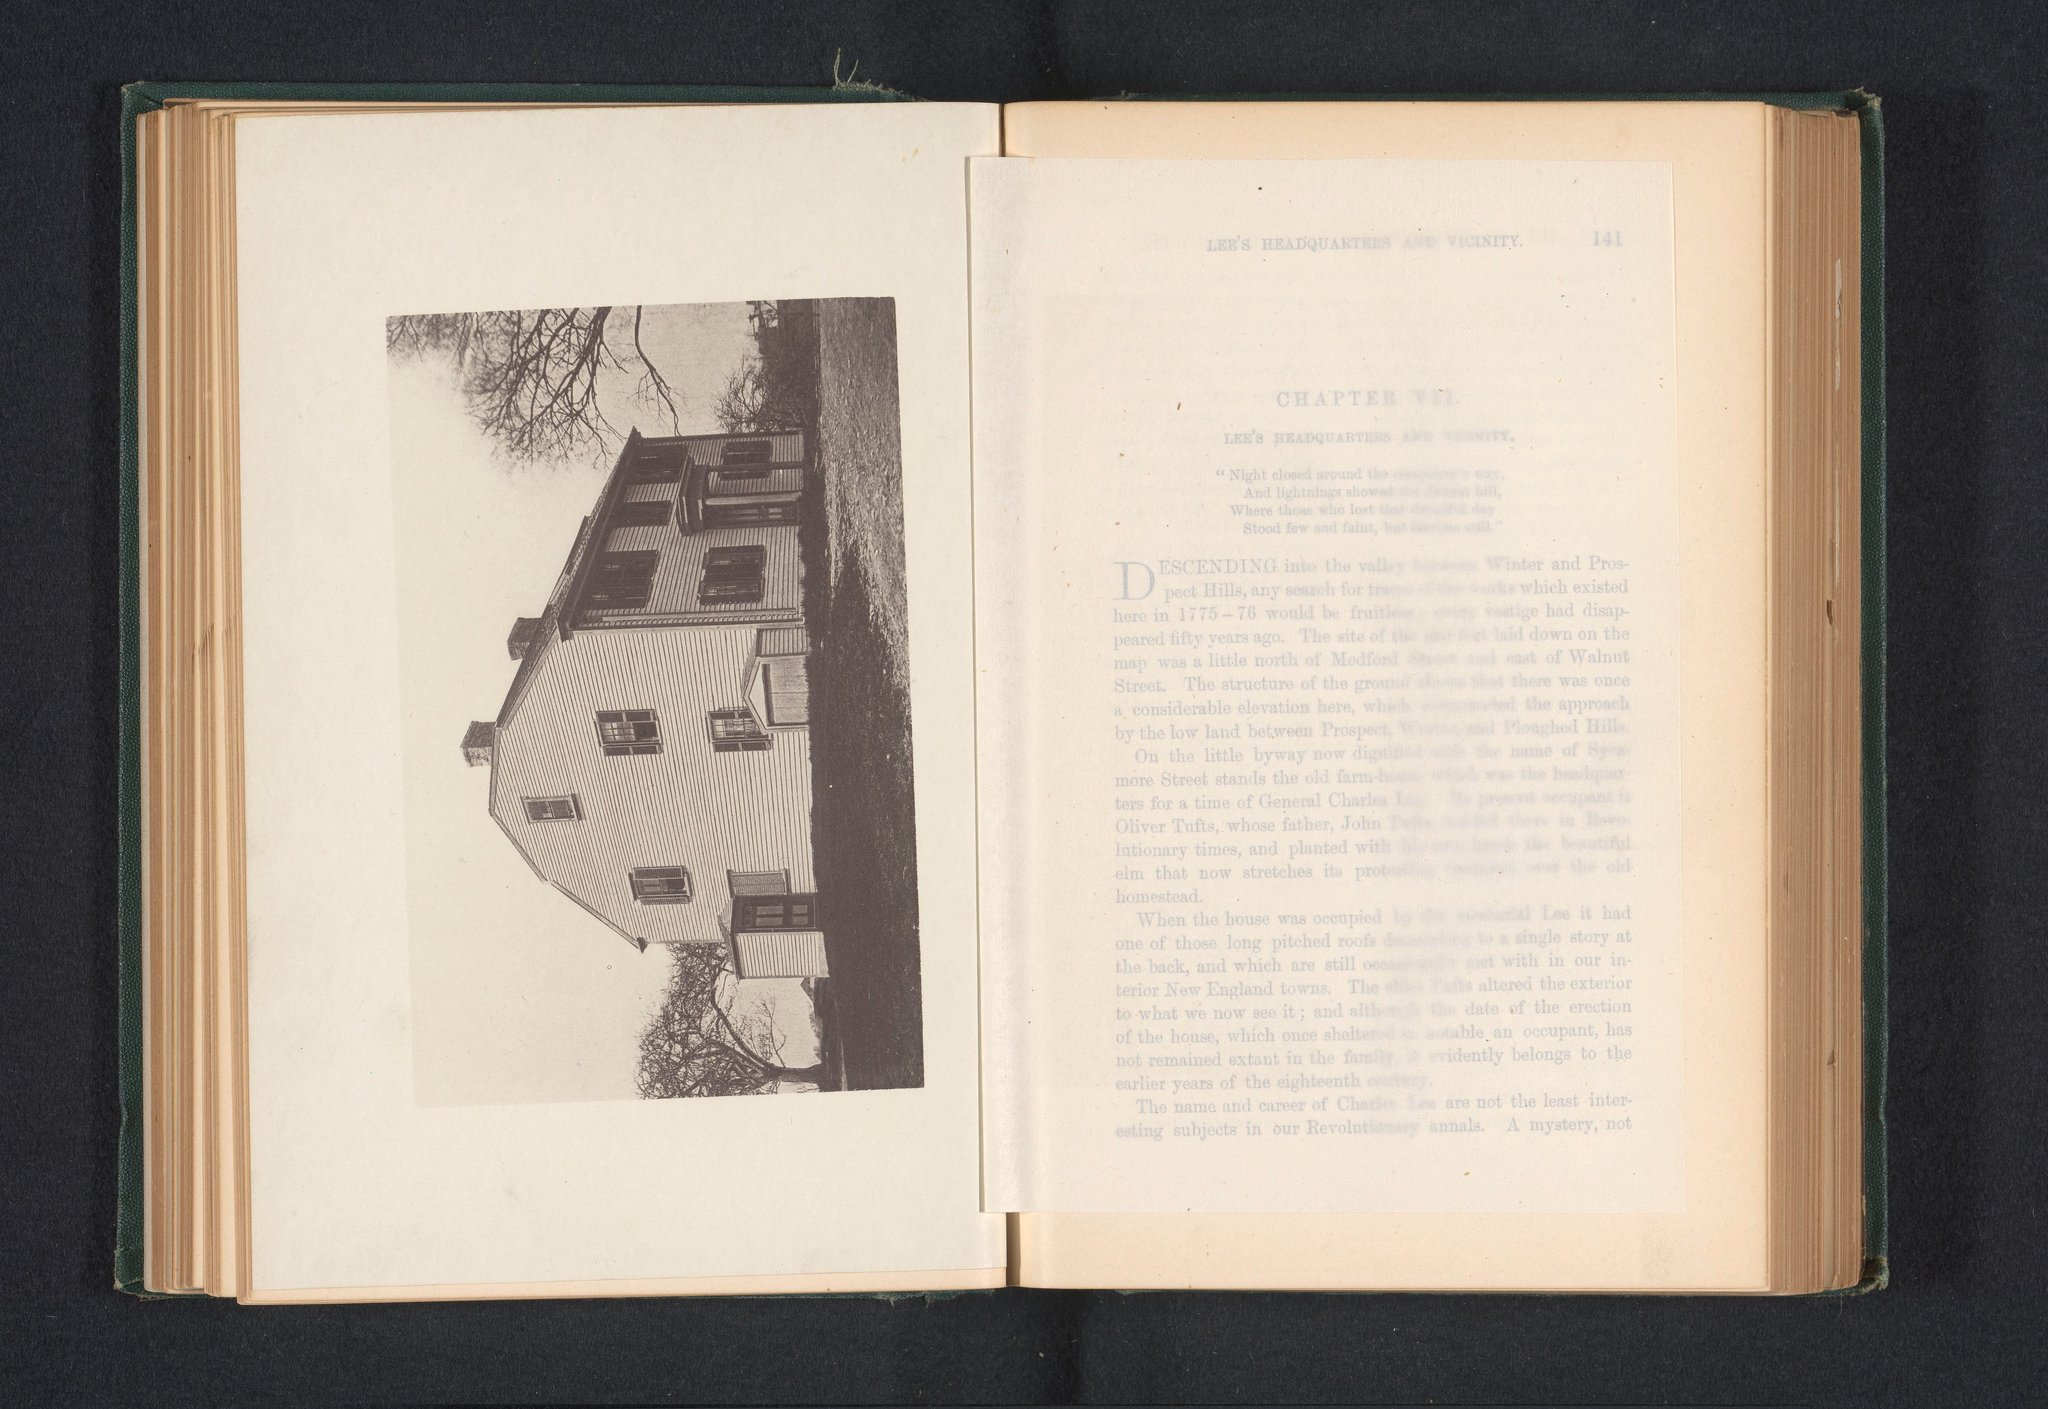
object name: photomechanical print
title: Gezicht op het hoofdkwartier van General Lee in Somerville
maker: Anonymous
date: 1869-1874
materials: paper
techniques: photograph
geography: somerville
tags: villa, façade (of house or building)